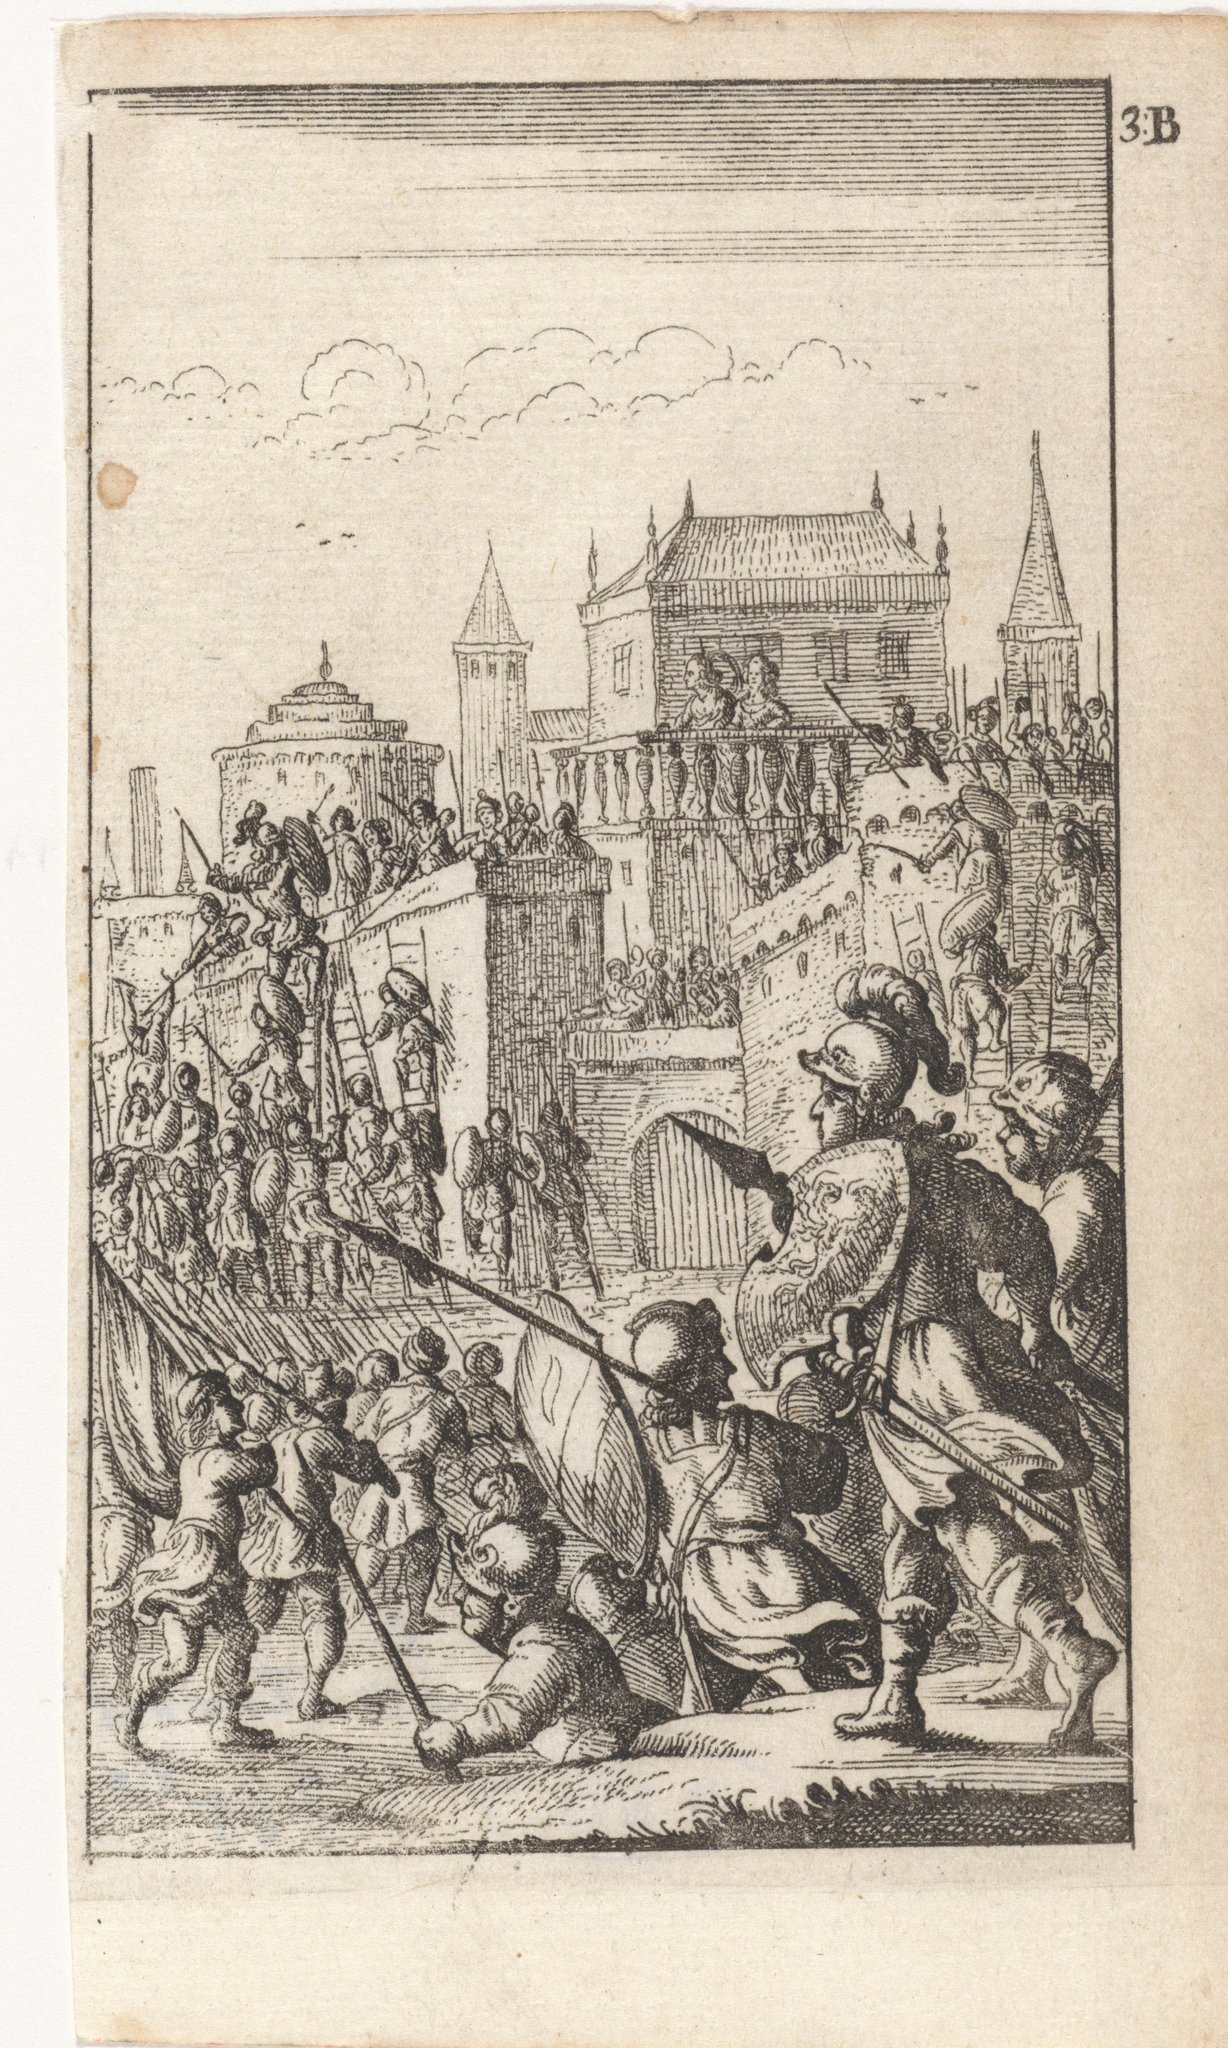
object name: book illustration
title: Soldaten bestormen een kasteel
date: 1667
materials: paper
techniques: etching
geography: netherlands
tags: (military) attack (+ during the battle), the soldier; the soldier's life (+ infantry)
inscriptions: collector's mark: Lugt 2228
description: De prent is gebruikt als boekillustratie in: Calprenède, La. Cleopatre 2de deel..., Amsterdam: Gerrit van Goedesberg, 1667